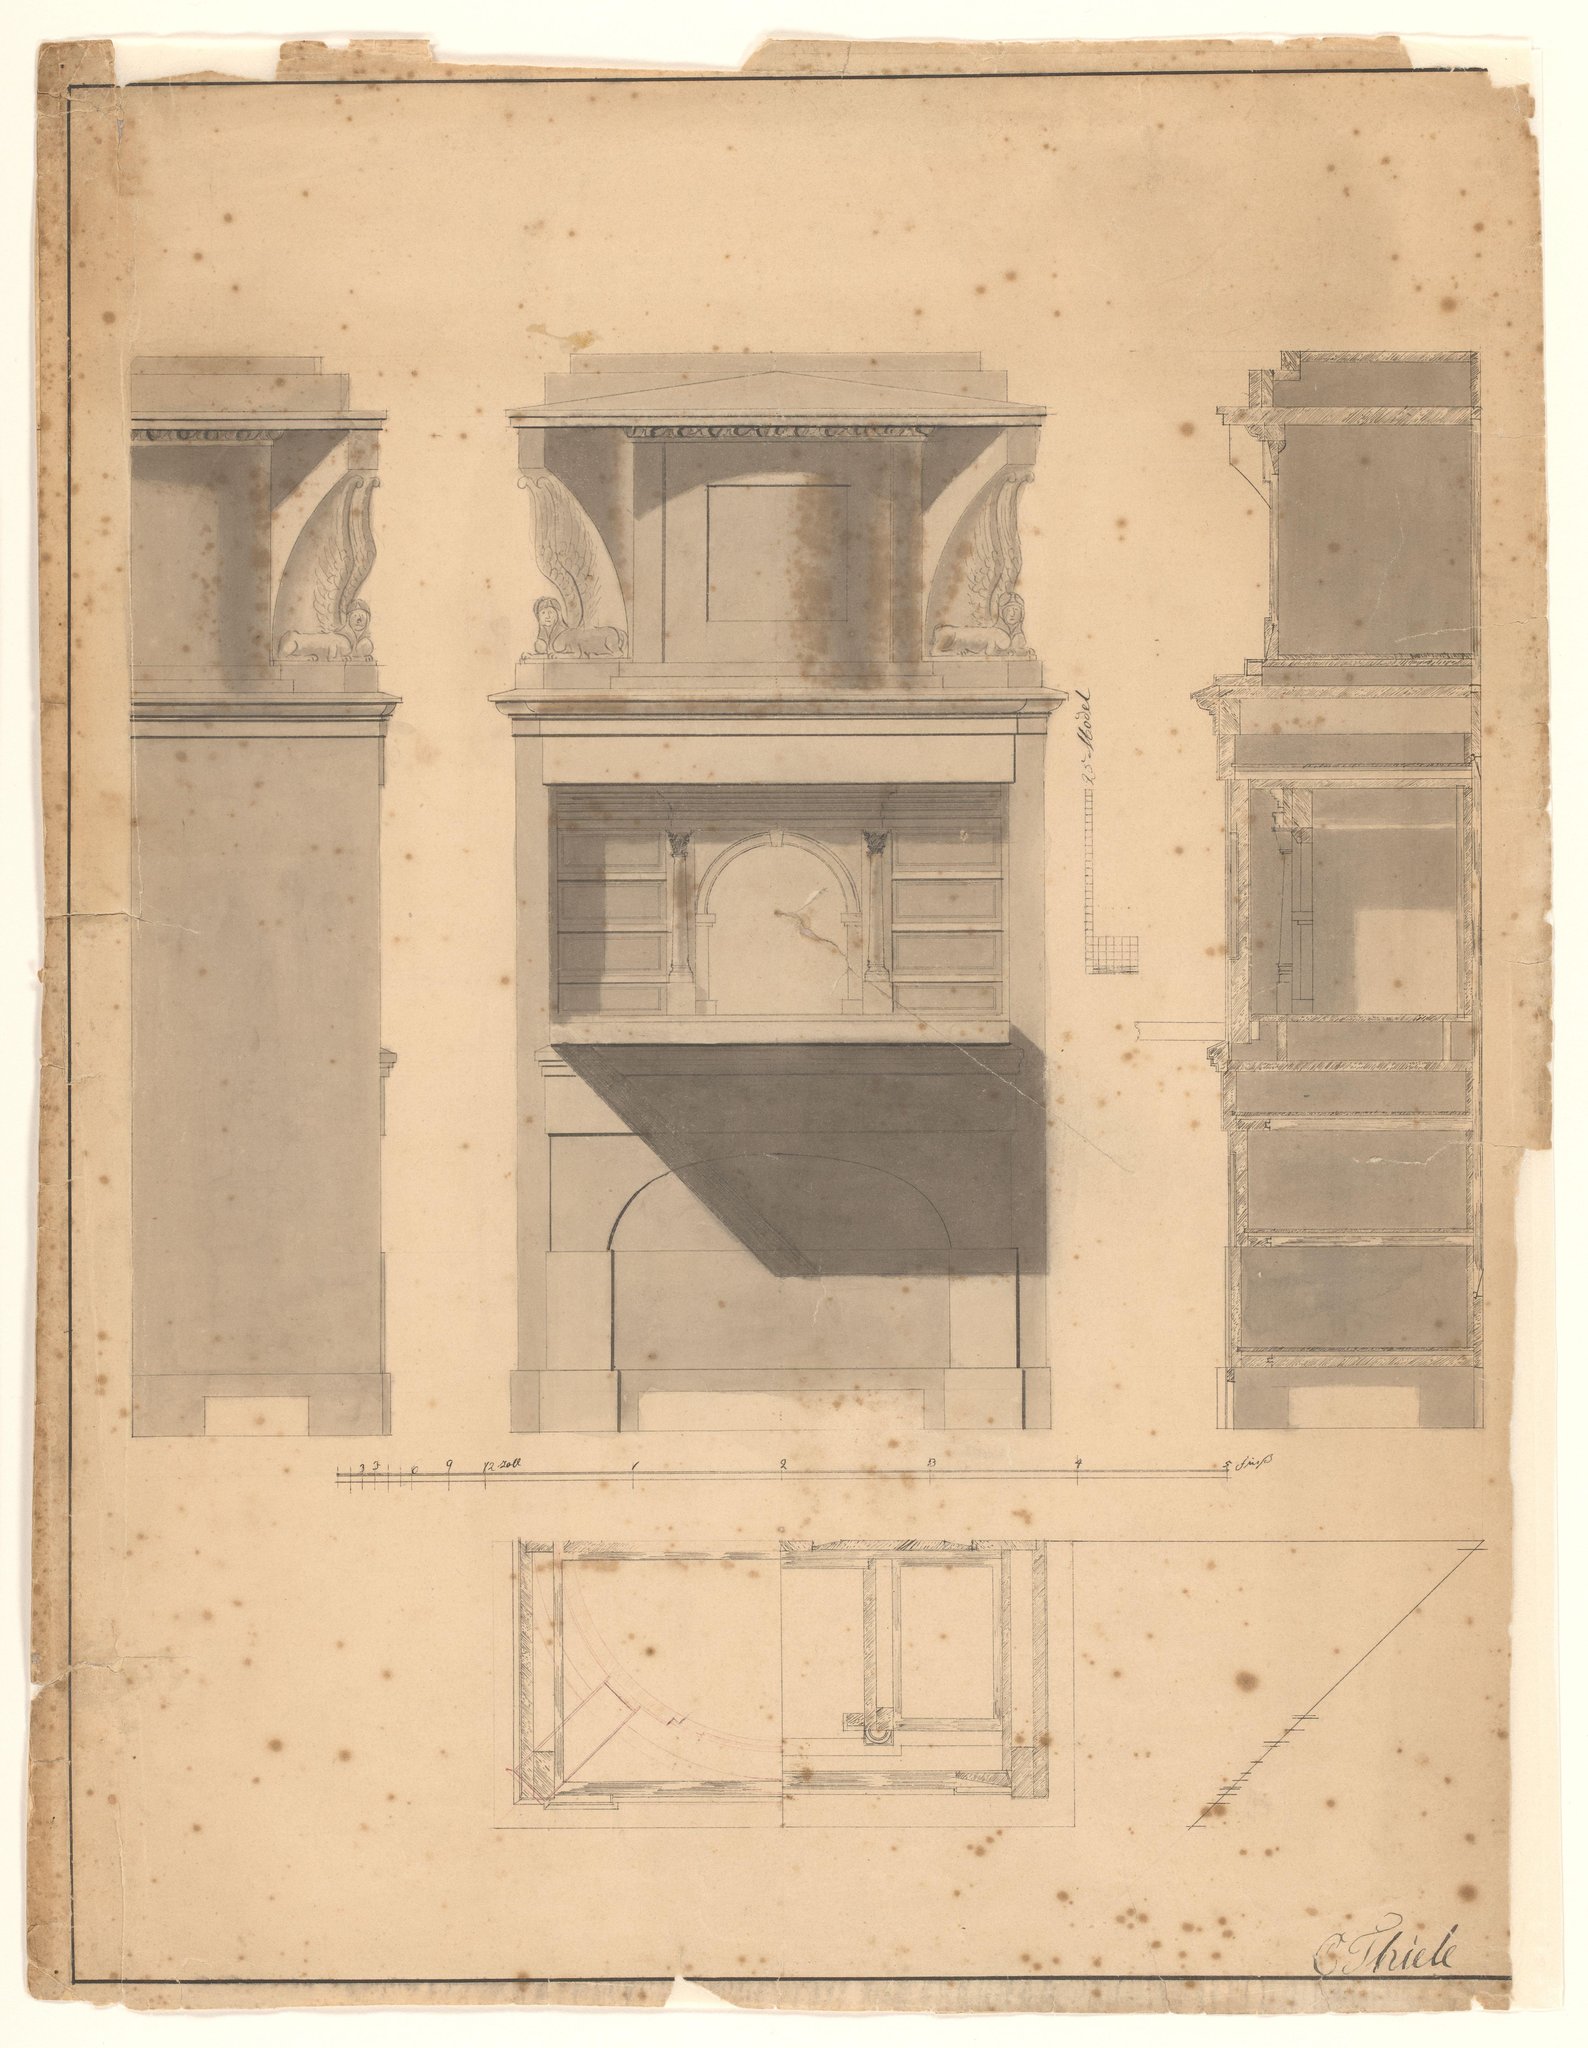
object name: design drawing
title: Ontwerp voor een secretaire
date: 1825-1835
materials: ink, paper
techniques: brush, pen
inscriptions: signature: ‘C. Thiele’, watermark: ‘GE’, inscription: ‘3 6 9 12 Zoll1 2 3 4 5 Fuβ / 25 Model’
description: Twee sfinxen, vooraanzicht en twee zijaanzichten, met daaronder een in tweeën gedeelde plattegrond en een maatverdeling.